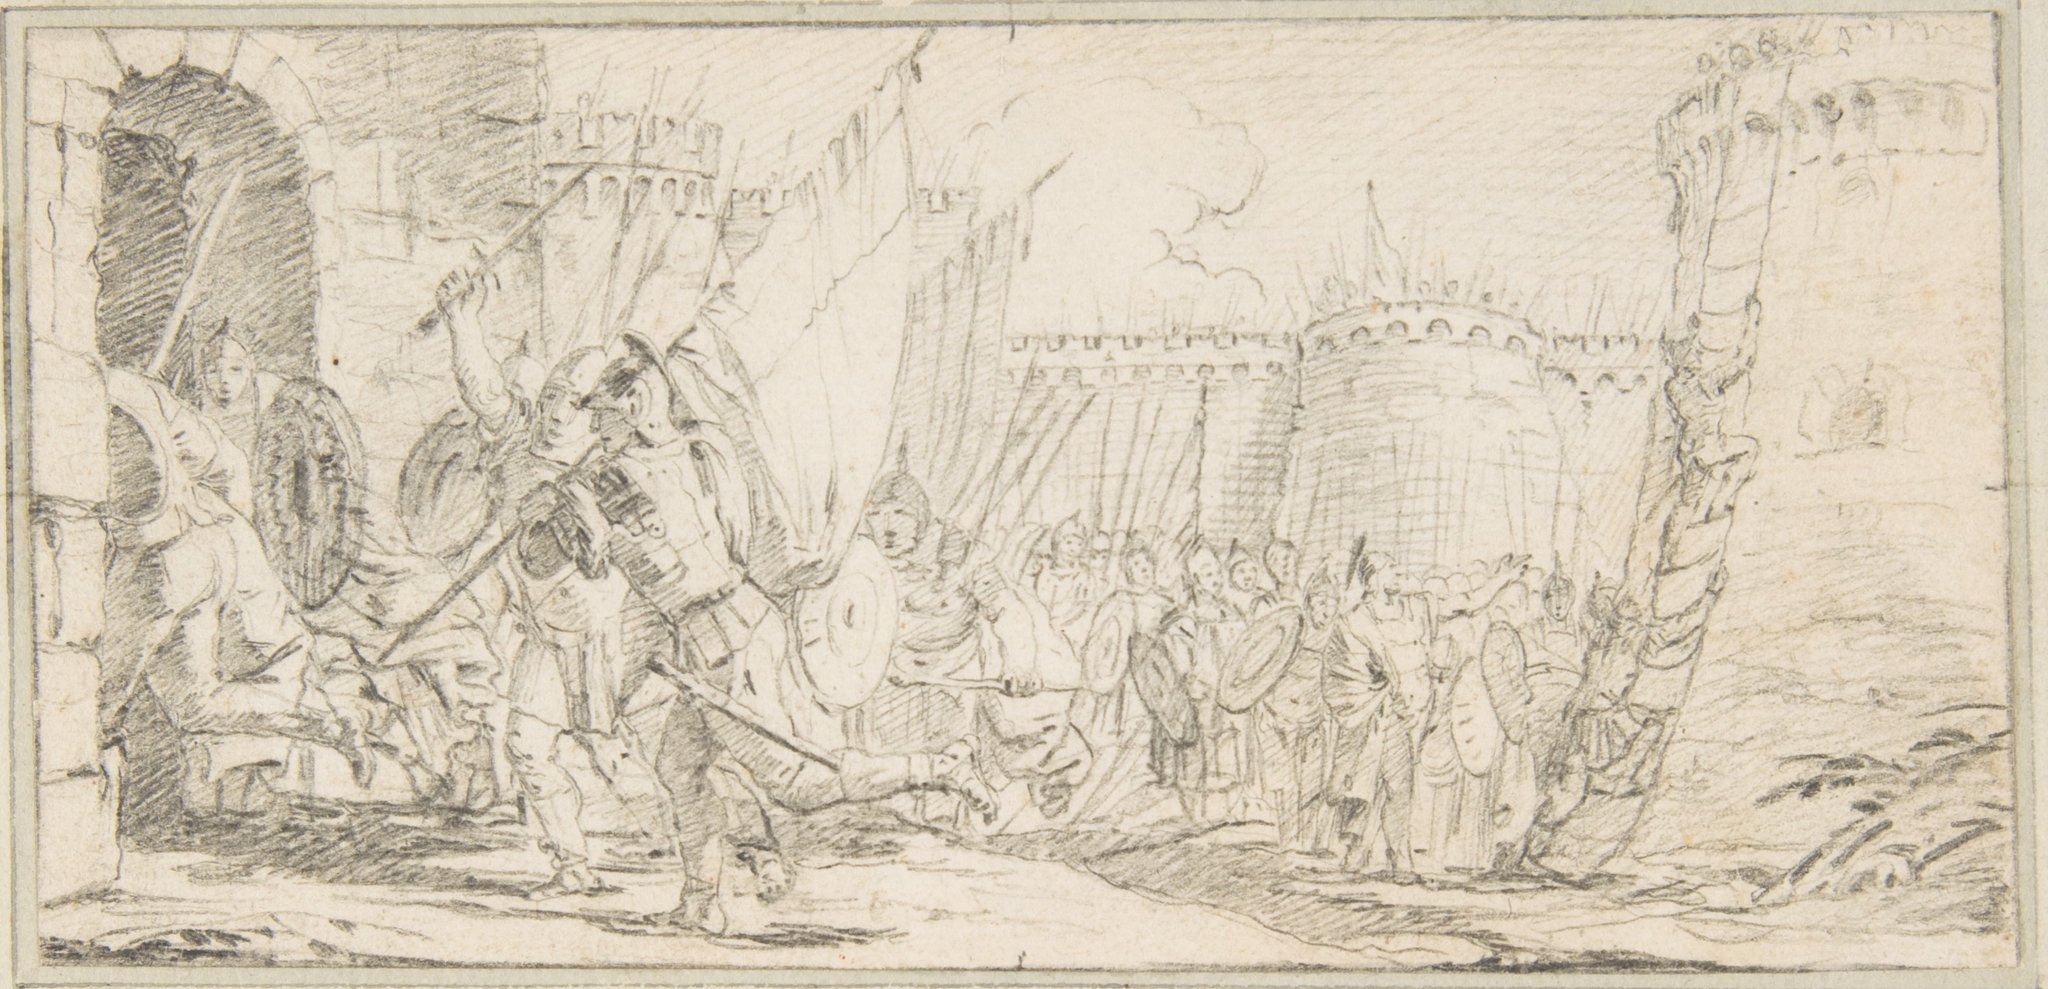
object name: drawing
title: Illustration for a Book: Soldiers Storming a City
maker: giovanni battista tiepolo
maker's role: artist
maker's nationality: italian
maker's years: 1696-1770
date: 1696-1770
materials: chalk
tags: soldiers,weapons,men